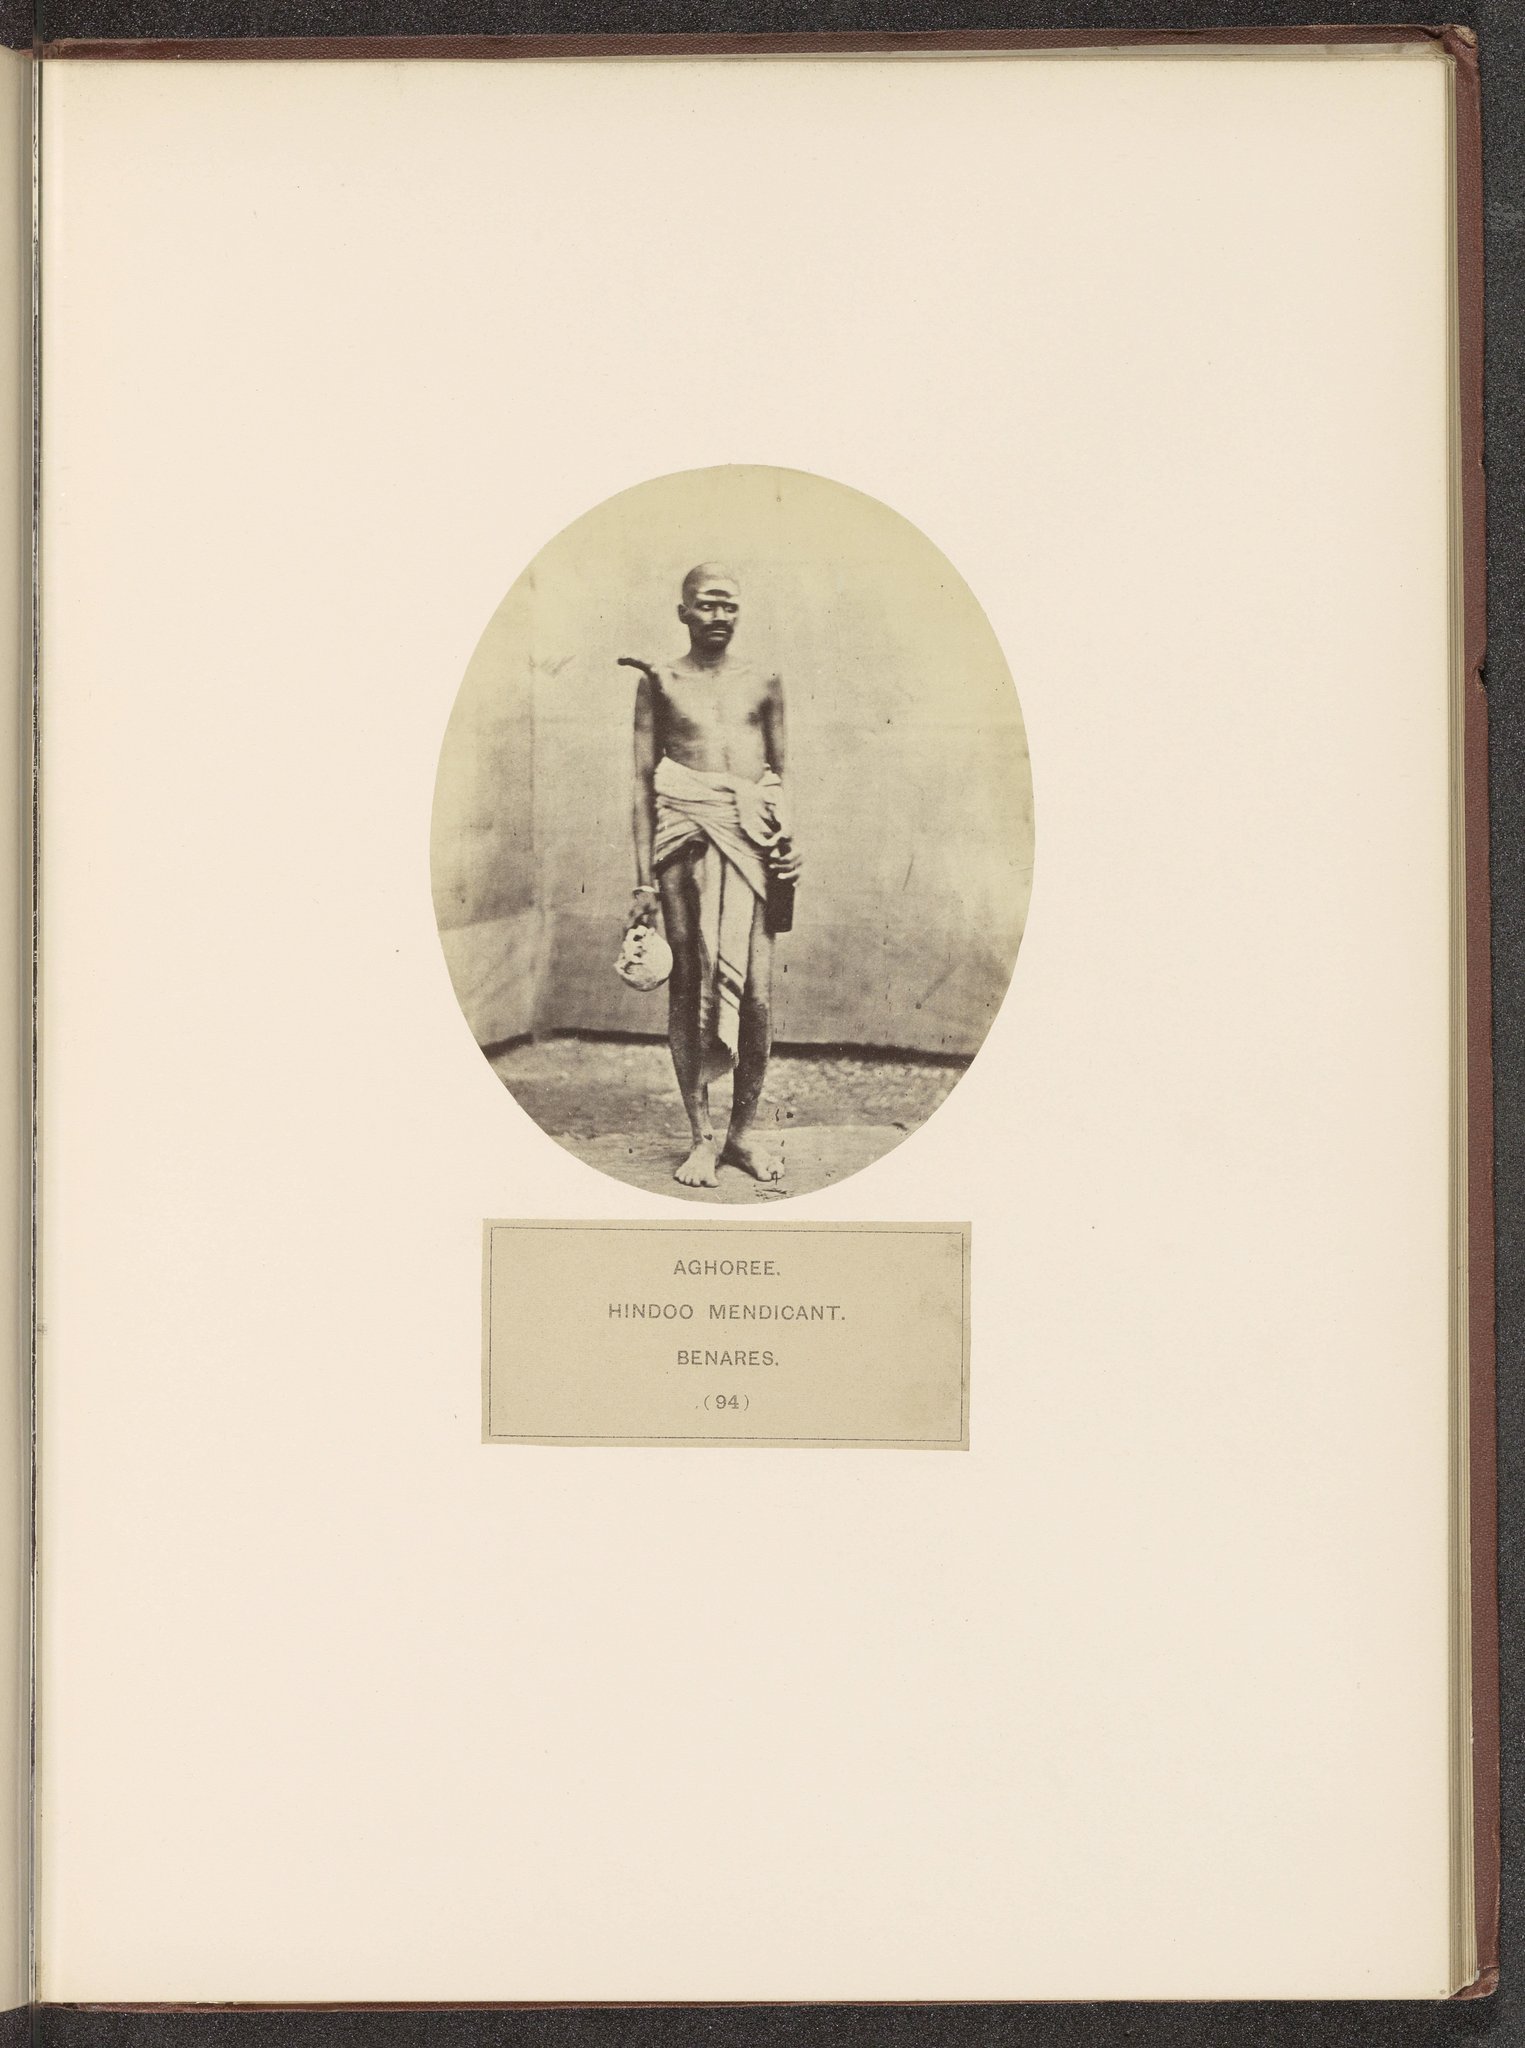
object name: photograph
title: Portrait of an unknown man from the Aghori mendicant community of Varanasi, Uttar Pradesh, India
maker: Anonymous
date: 1858-1868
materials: photographic support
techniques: albumen print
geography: varanasi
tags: hinduism, buddhism, jainism, human races; peoples; nationalities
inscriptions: number: ‘(94)’, inscription: ‘AGHOREE./ HINDOO MENDICANT./ BENARES.’